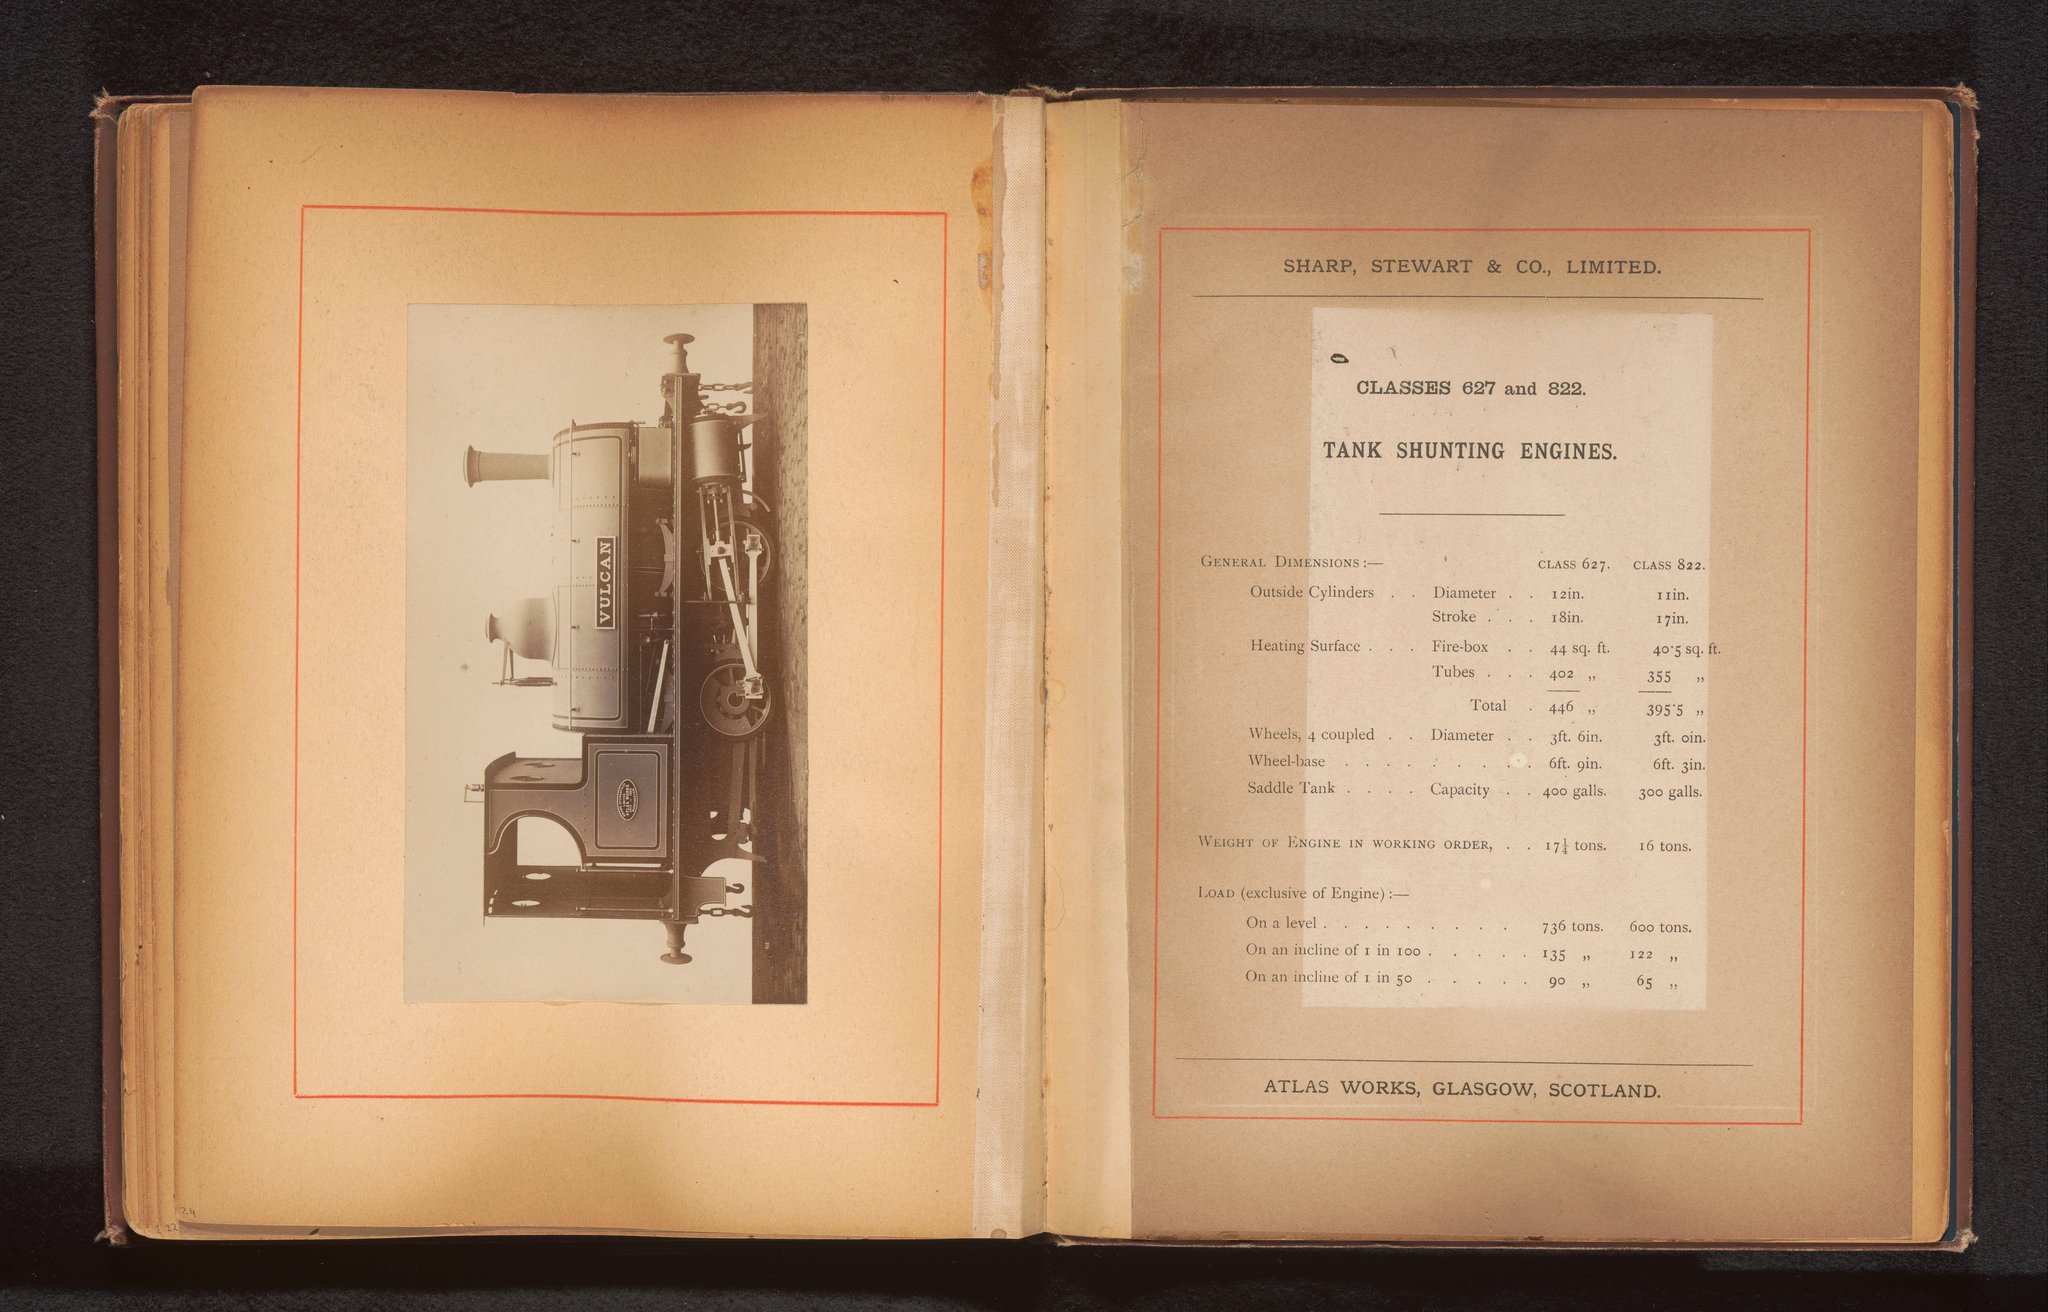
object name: photograph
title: Stoomlocomotief gemaakt door Sharp, Stewart and Company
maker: Anonymous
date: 1874-1884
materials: photographic support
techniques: albumen print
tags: steam locomotive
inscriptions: number: ‘915’, inscription: ‘Classes 627 and 822. Tank shunting engines.’